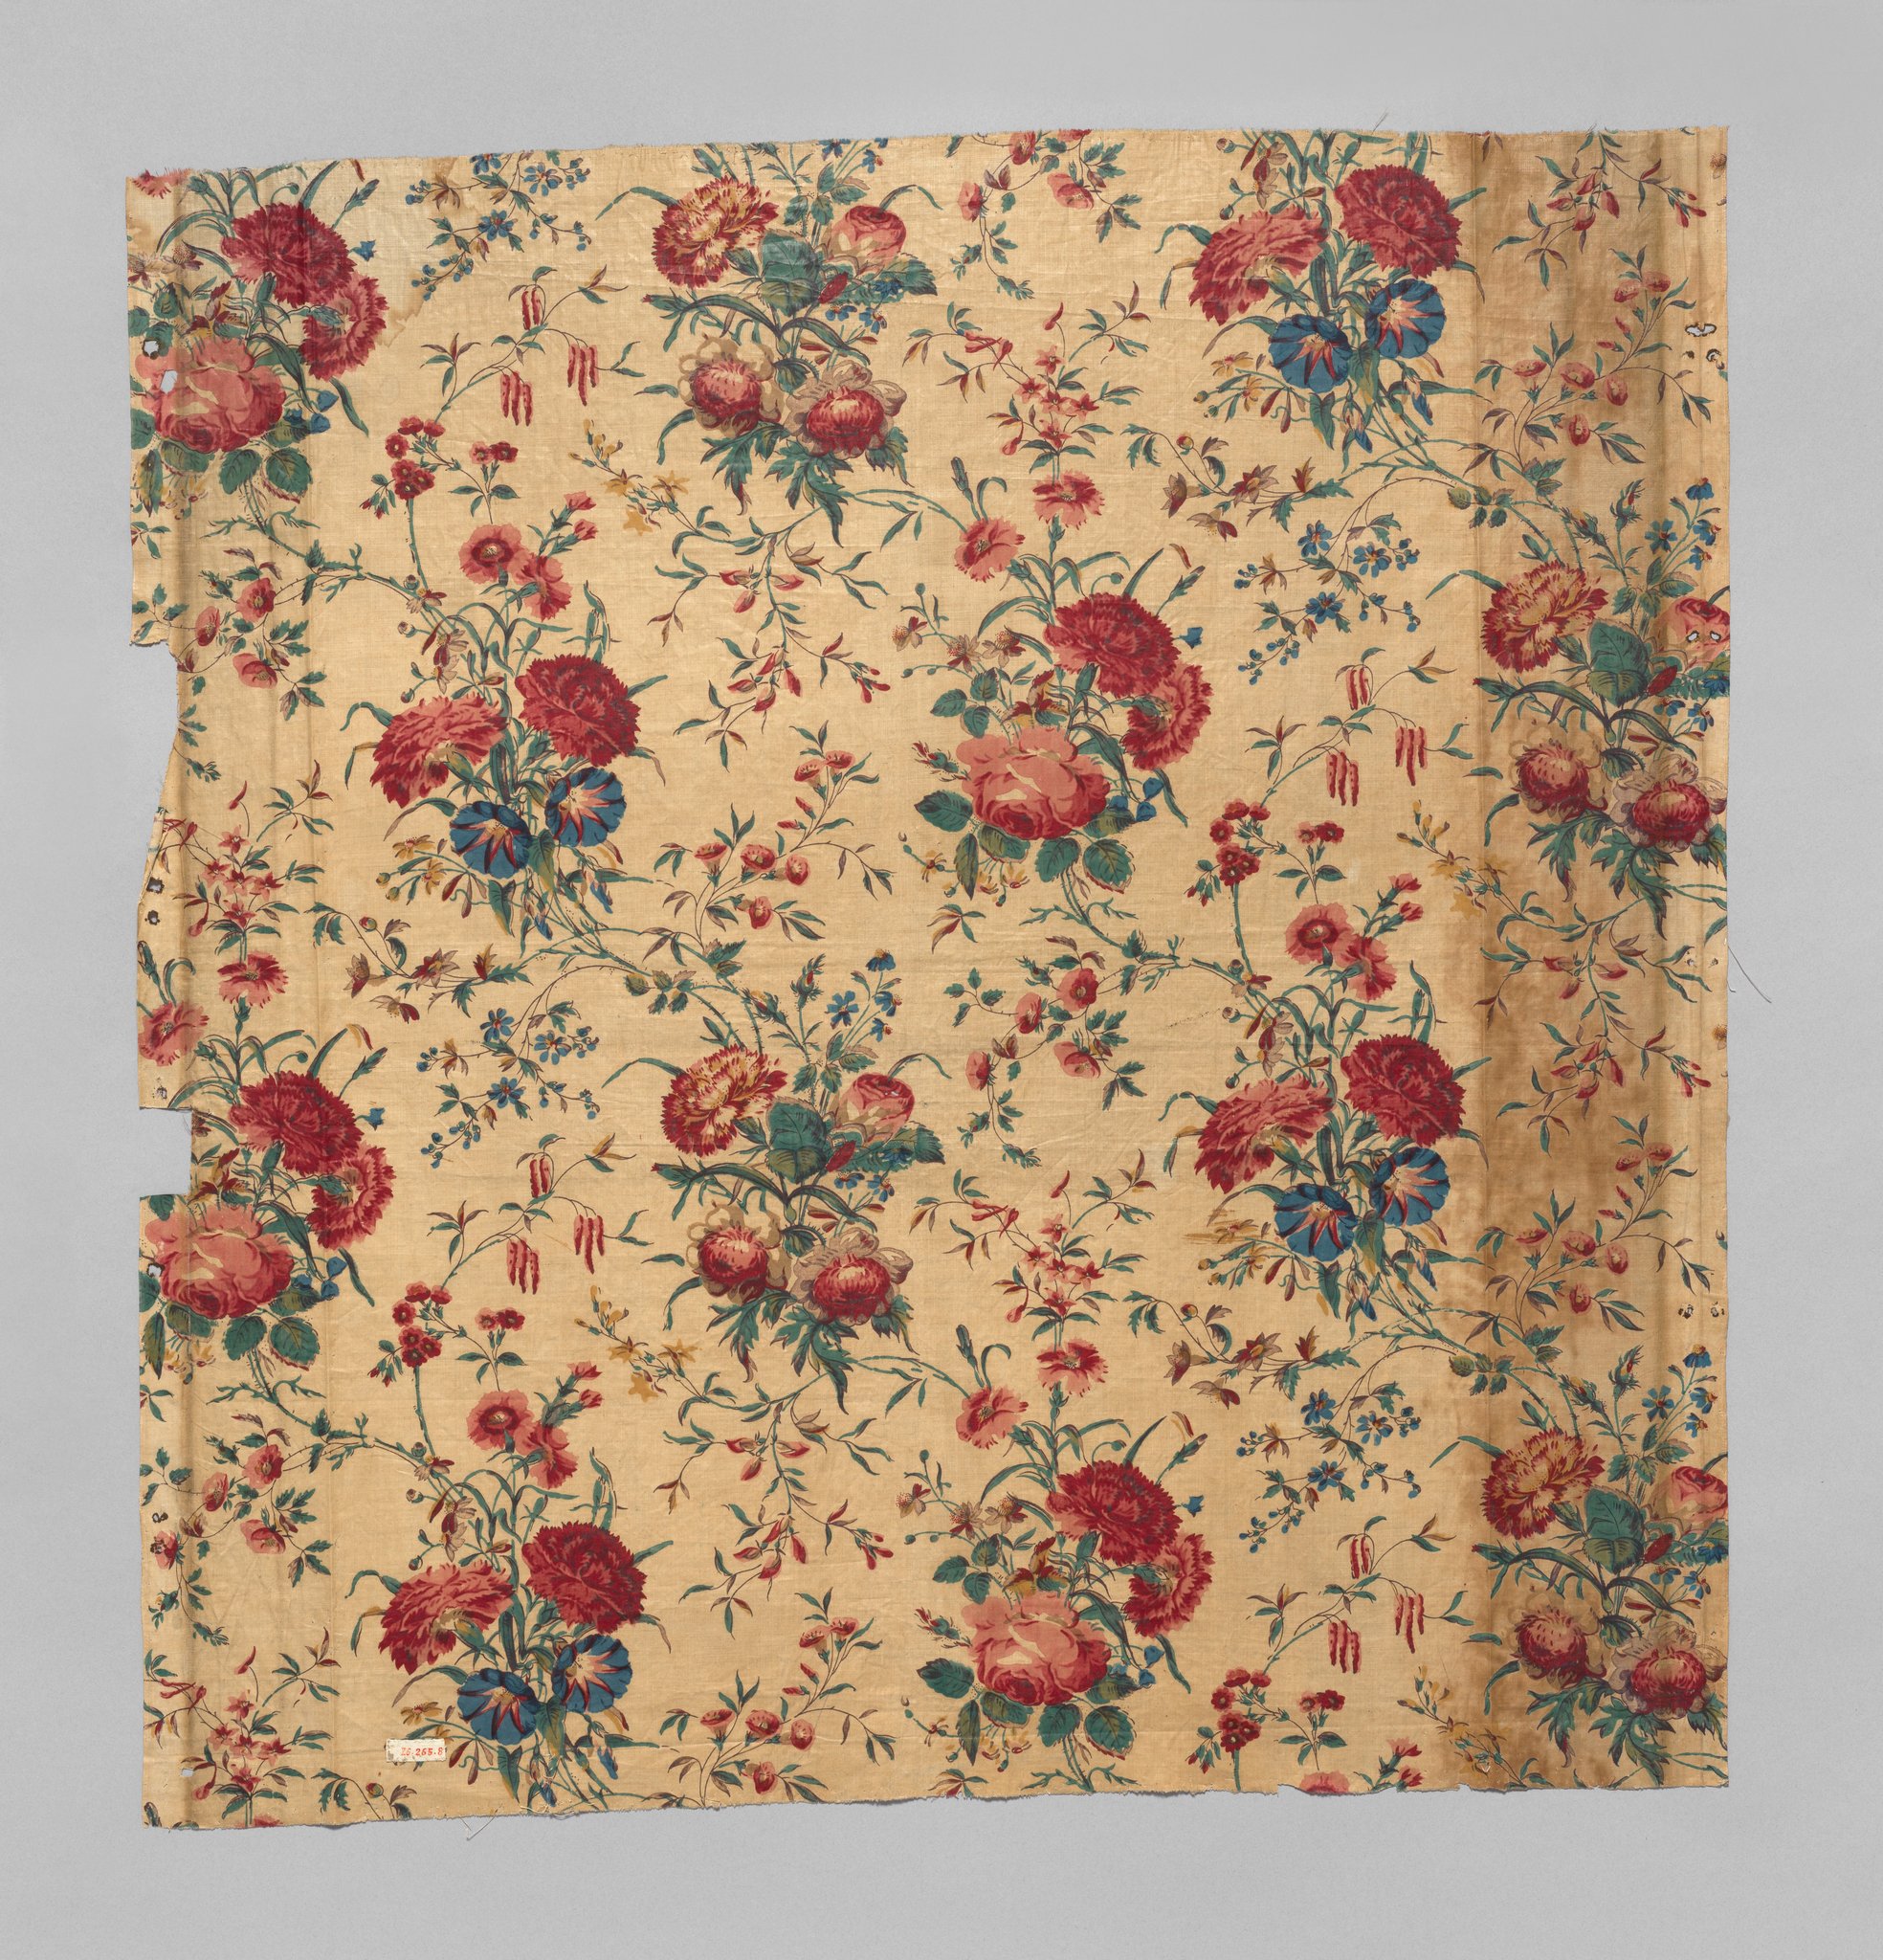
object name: piece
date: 1835-1845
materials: cotton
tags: flowers